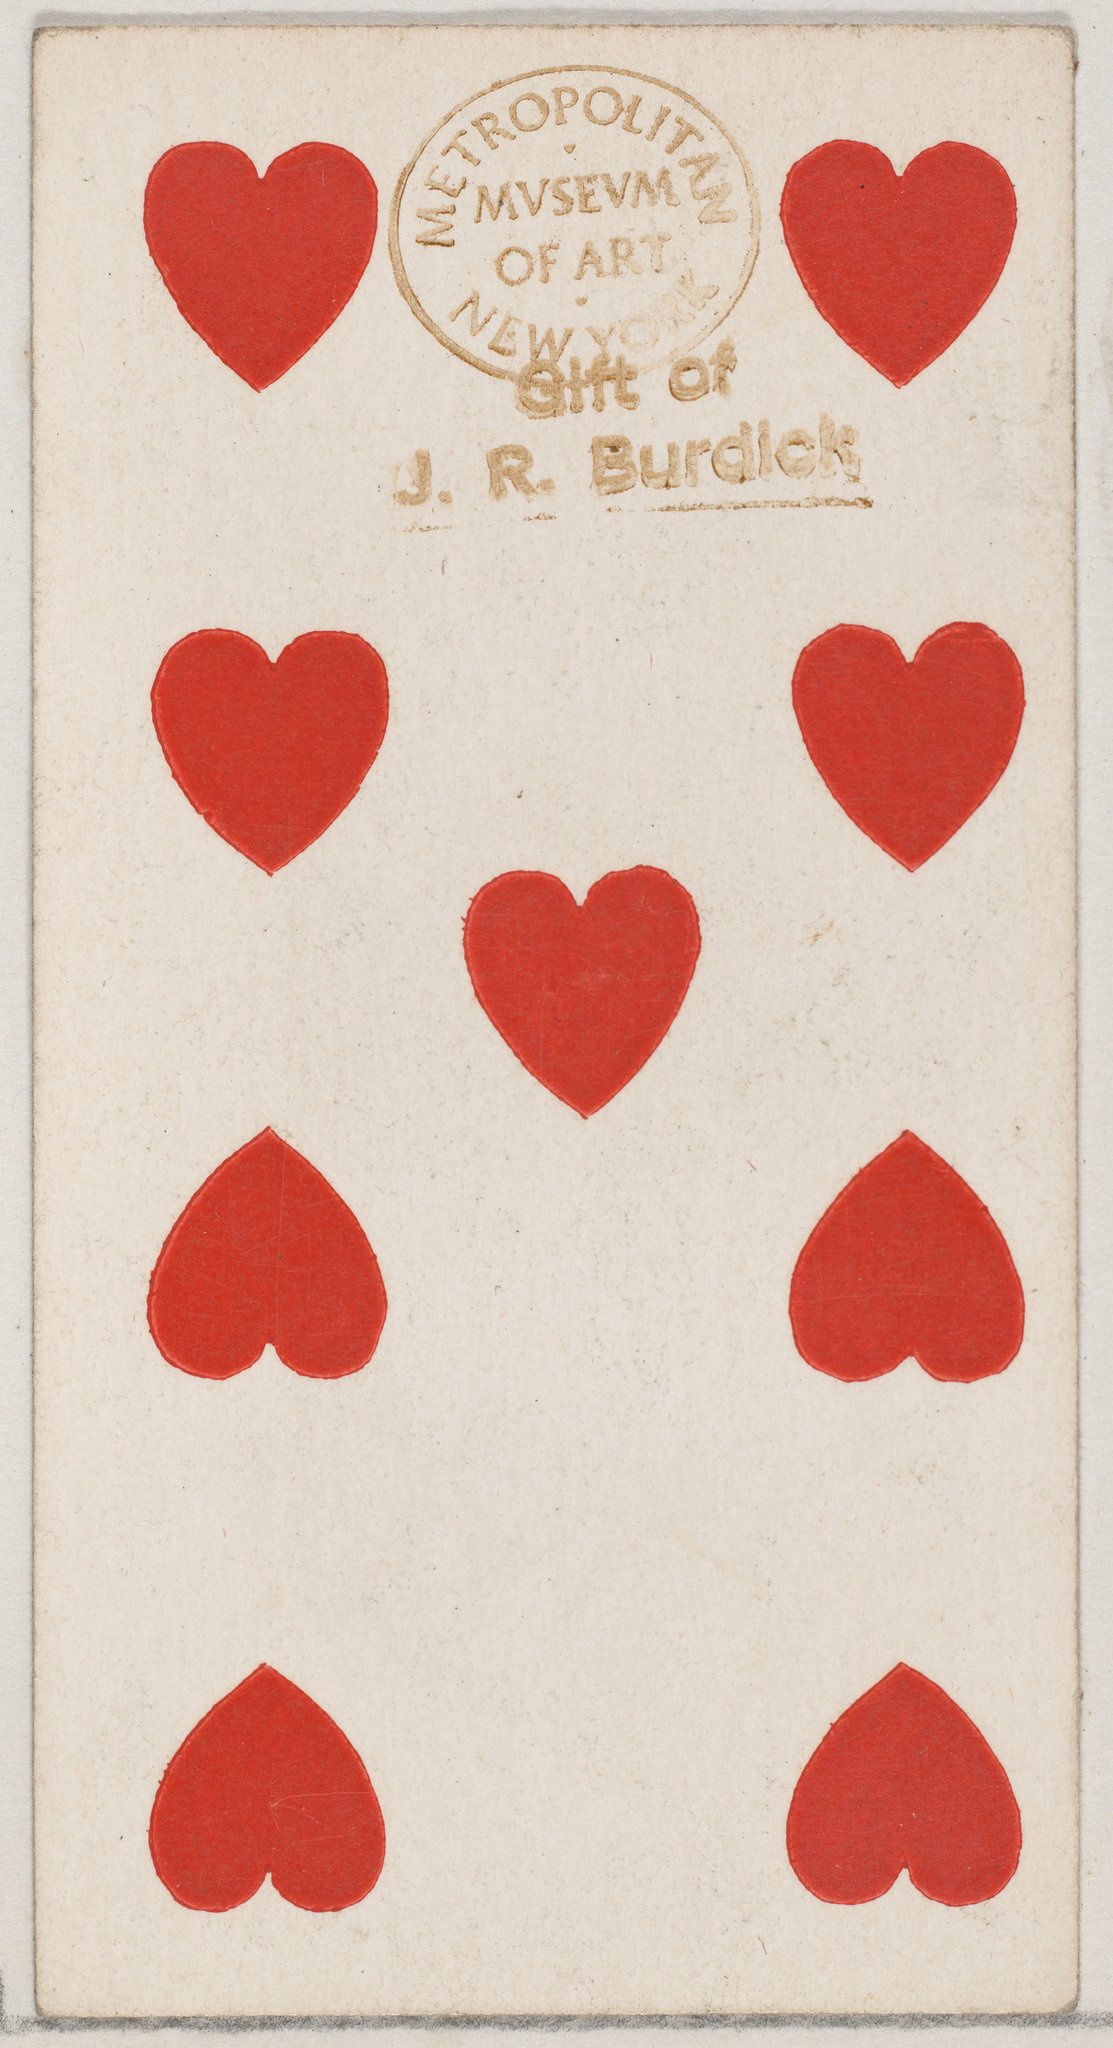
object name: print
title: Nine Hearts, from the Playing Cards series (N84) to promote Turkish Cross-Cut Cigarettes for W. Duke, Sons and Co.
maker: w. duke, sons & co.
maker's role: publisher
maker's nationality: american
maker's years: 1870-1920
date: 1888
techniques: color lithograph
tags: playing cards